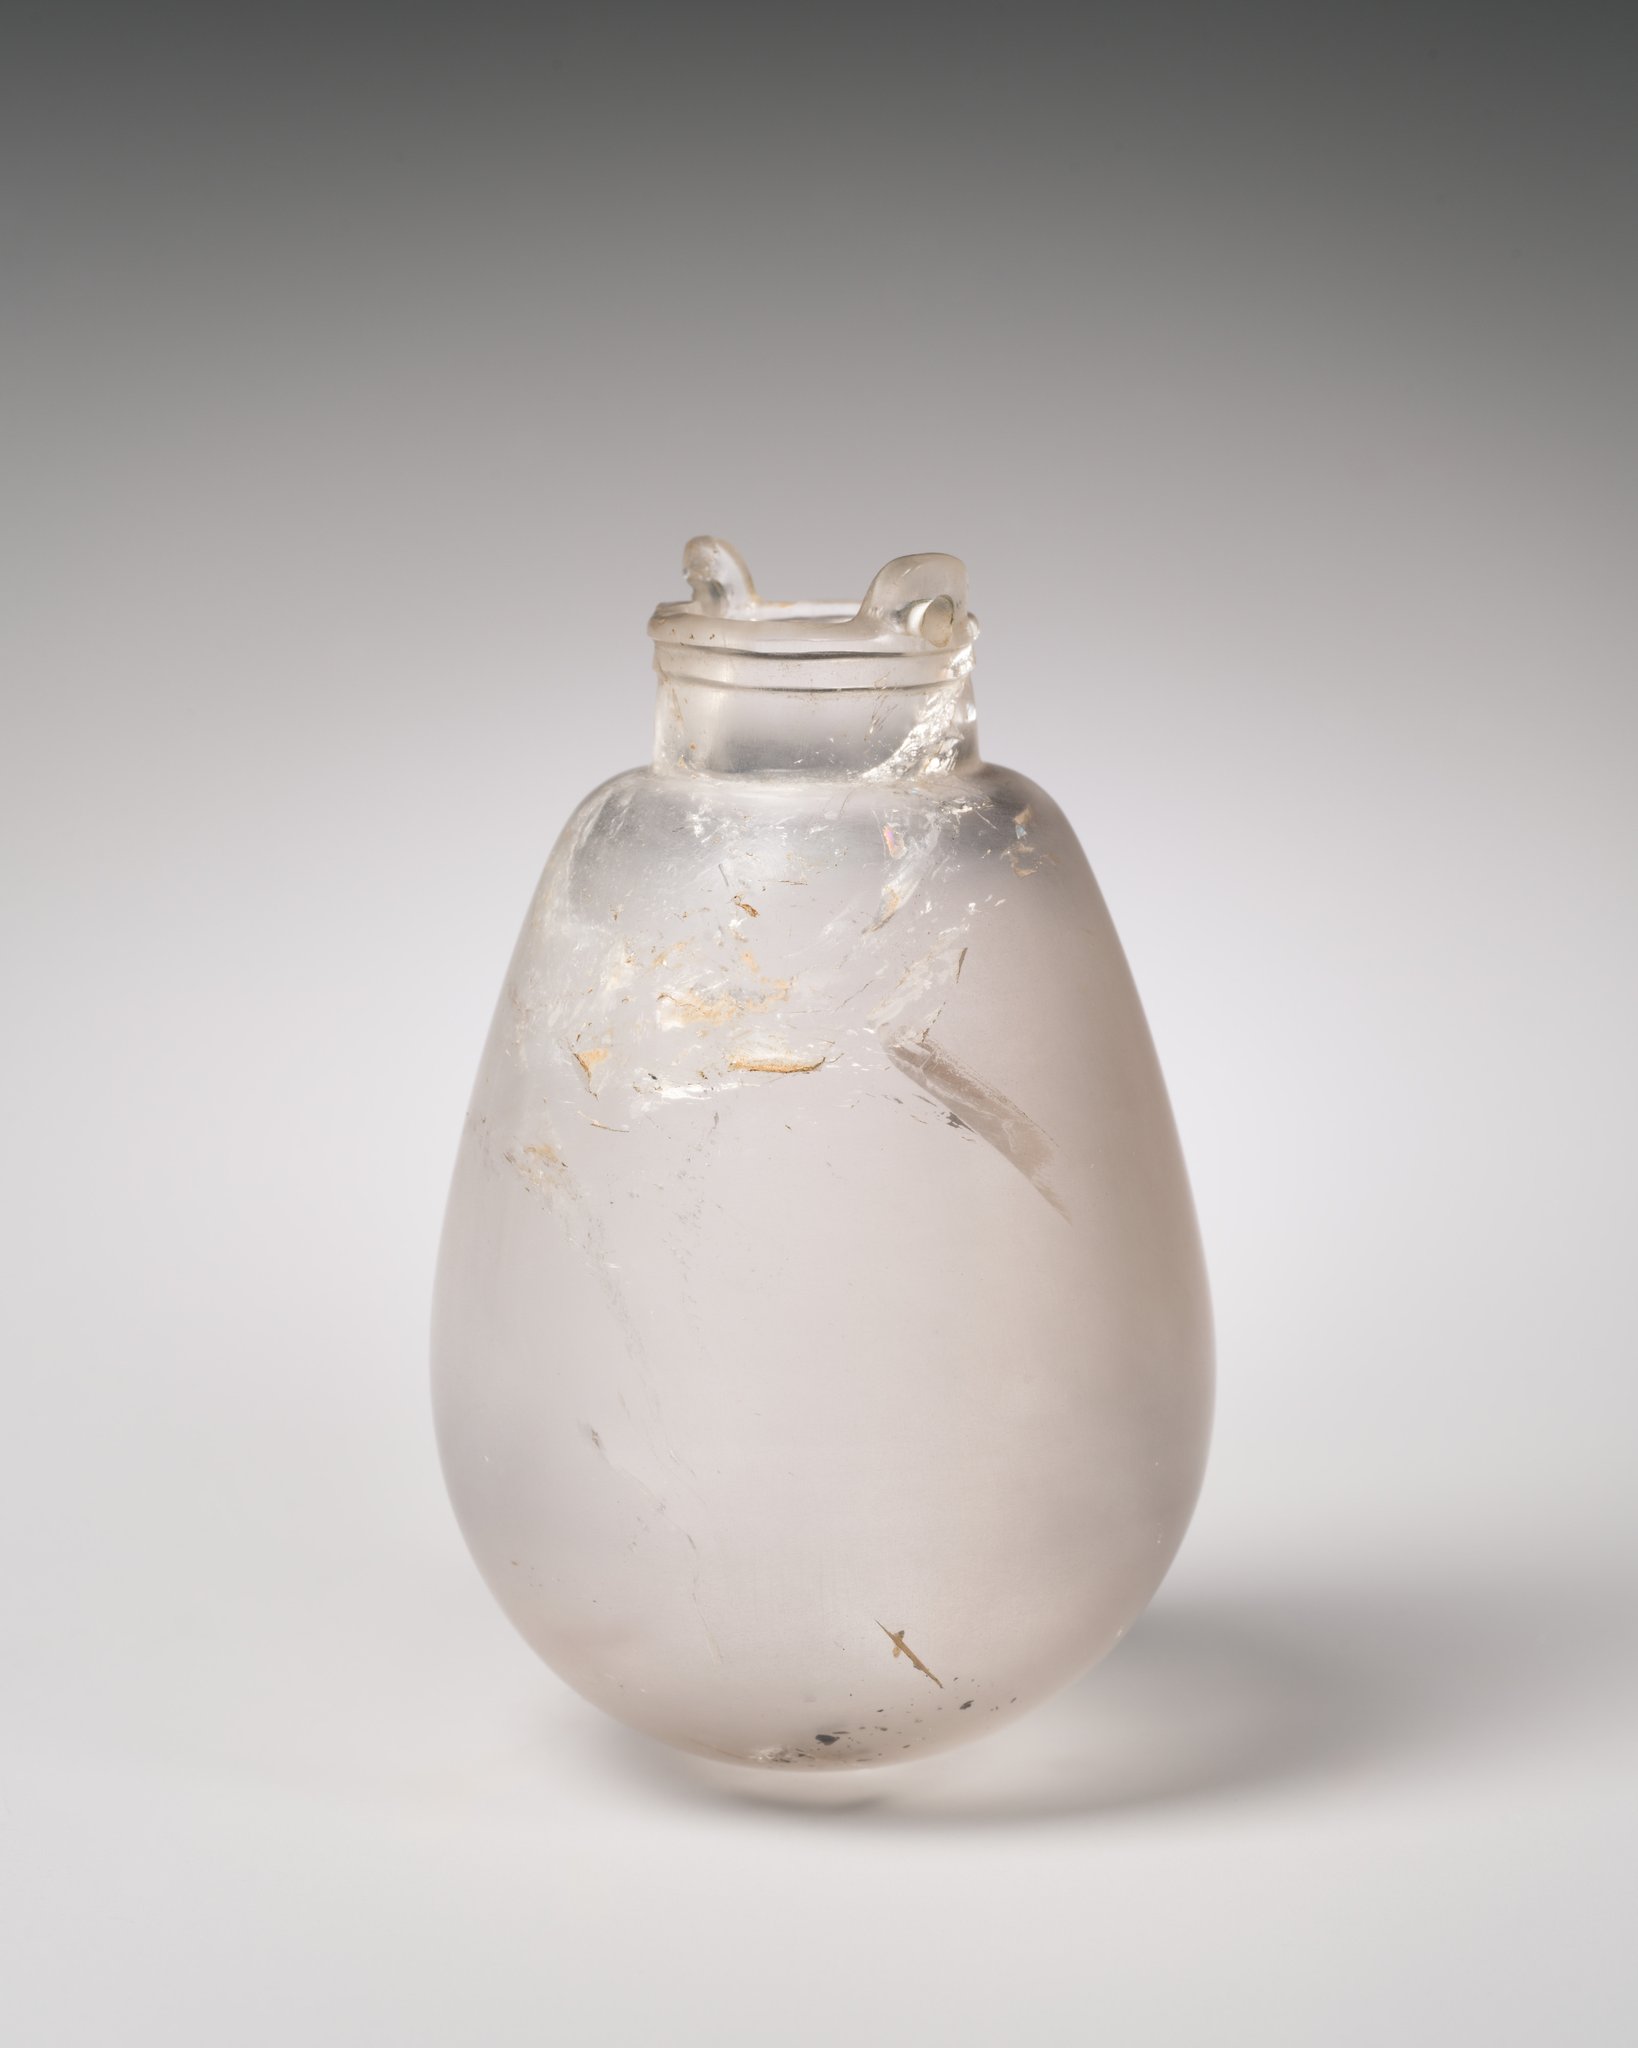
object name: scent bottle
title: Rock crystal bottle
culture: cypriot or phoenician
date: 500-101 BCE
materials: quartz